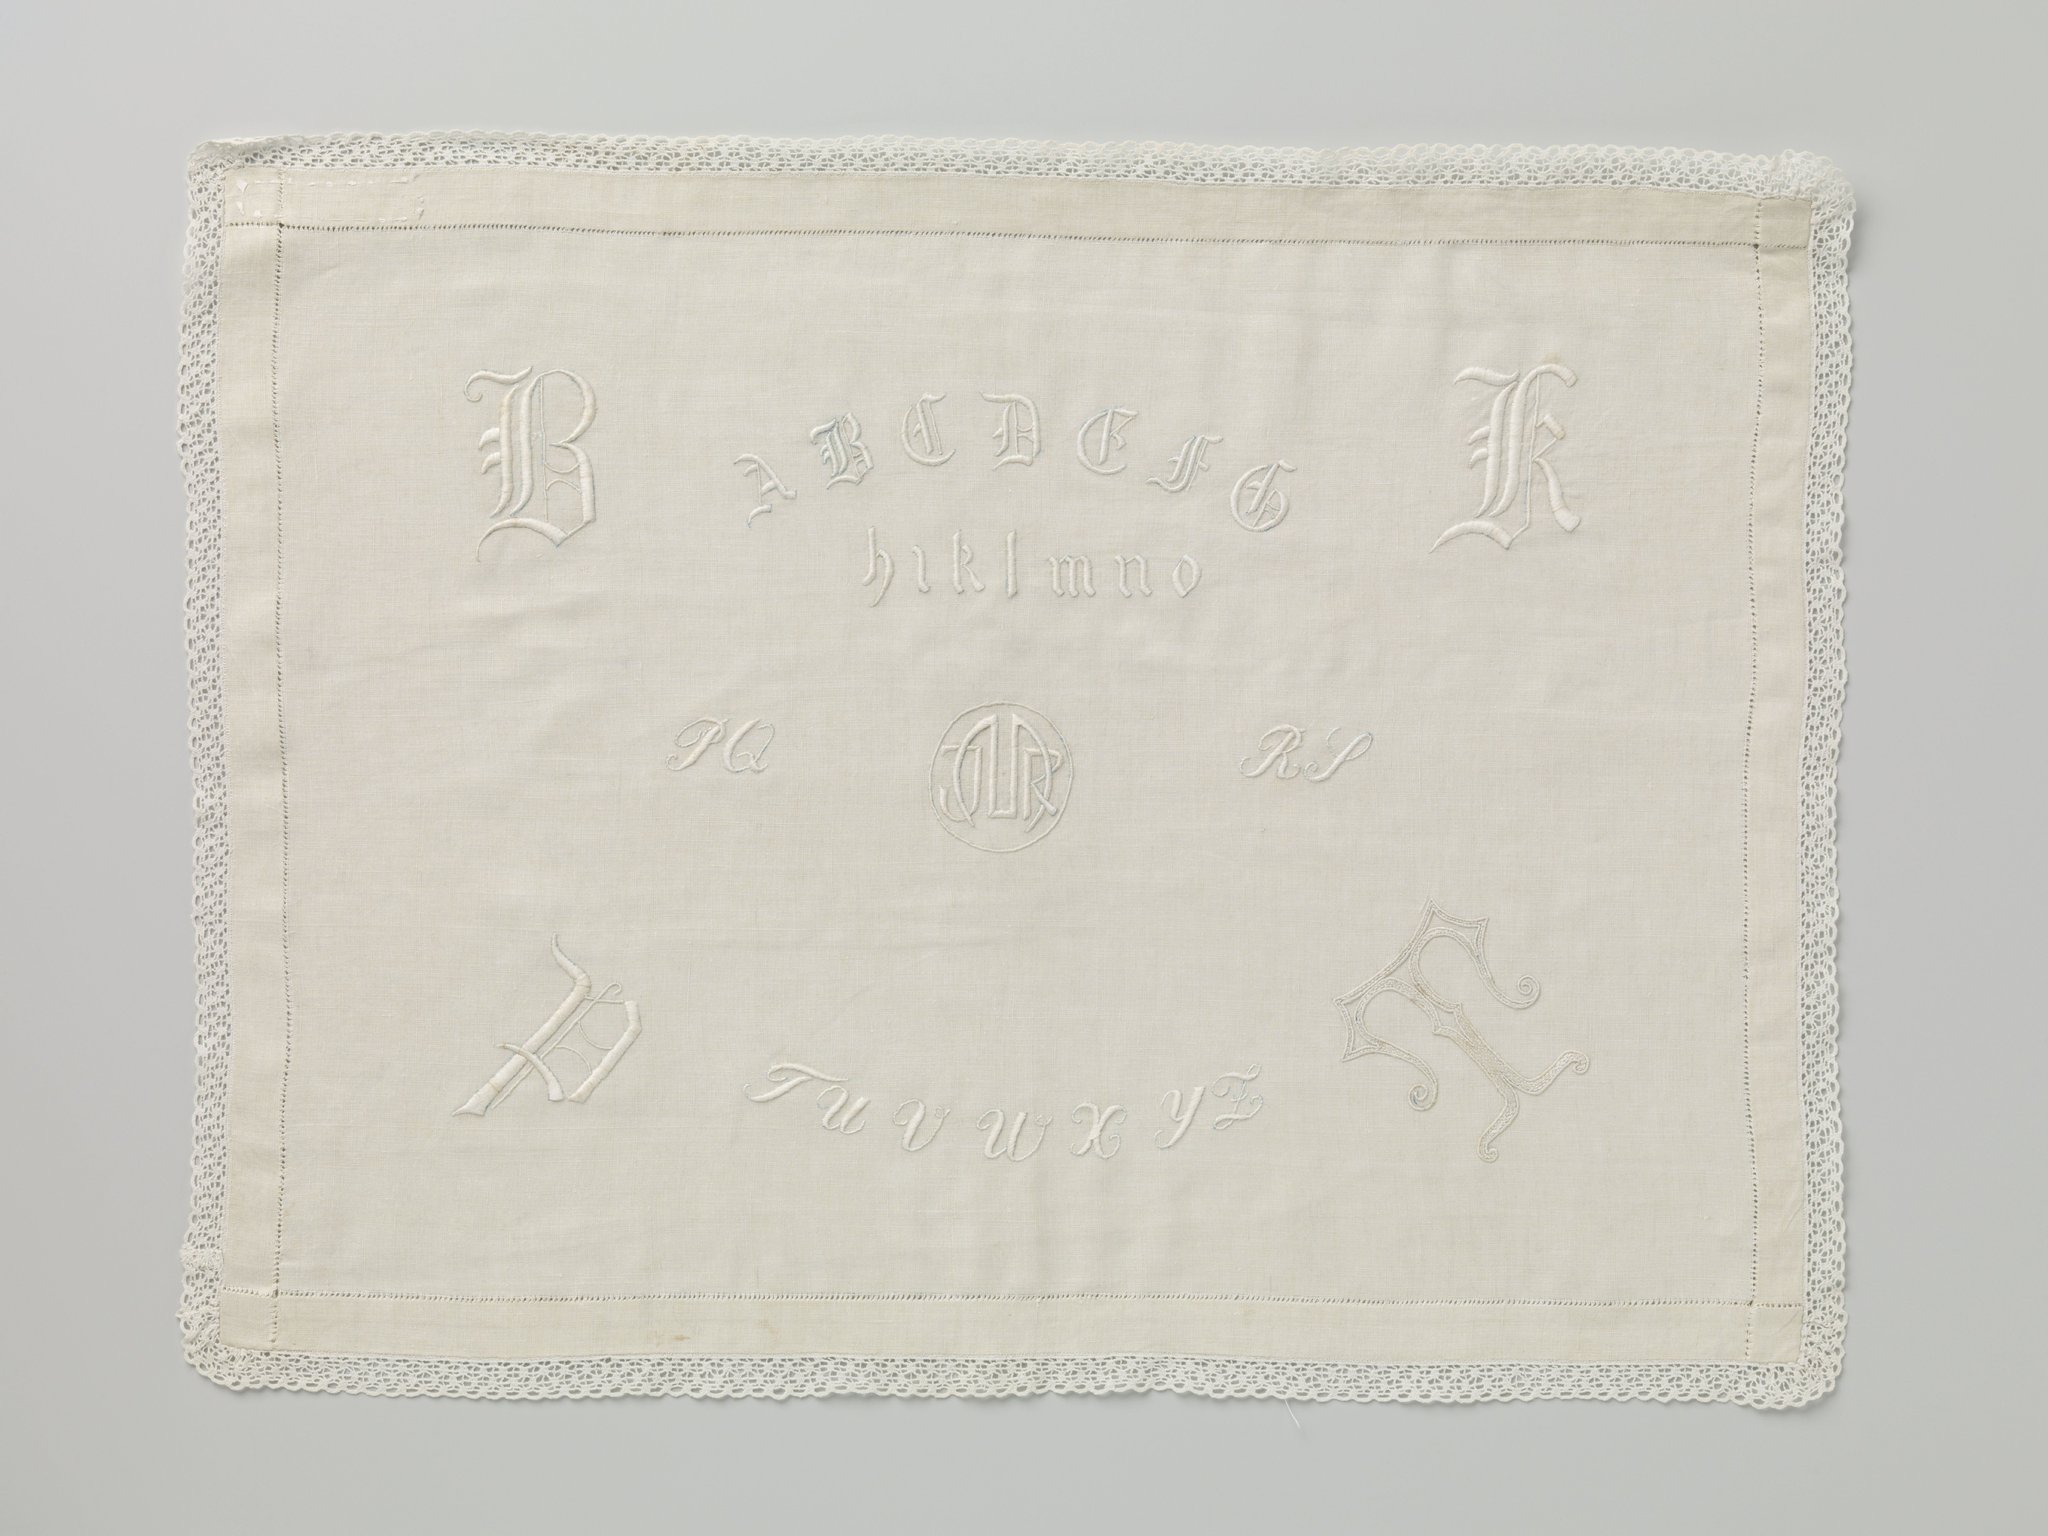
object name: merkdoek, merklap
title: Borduurlap van linnen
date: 1880-1905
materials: linen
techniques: embroidered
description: Borduurlap van wit garen op linnen. Het borduurwerk heeft eenmaal het alfabet en Frans borduurwerk.